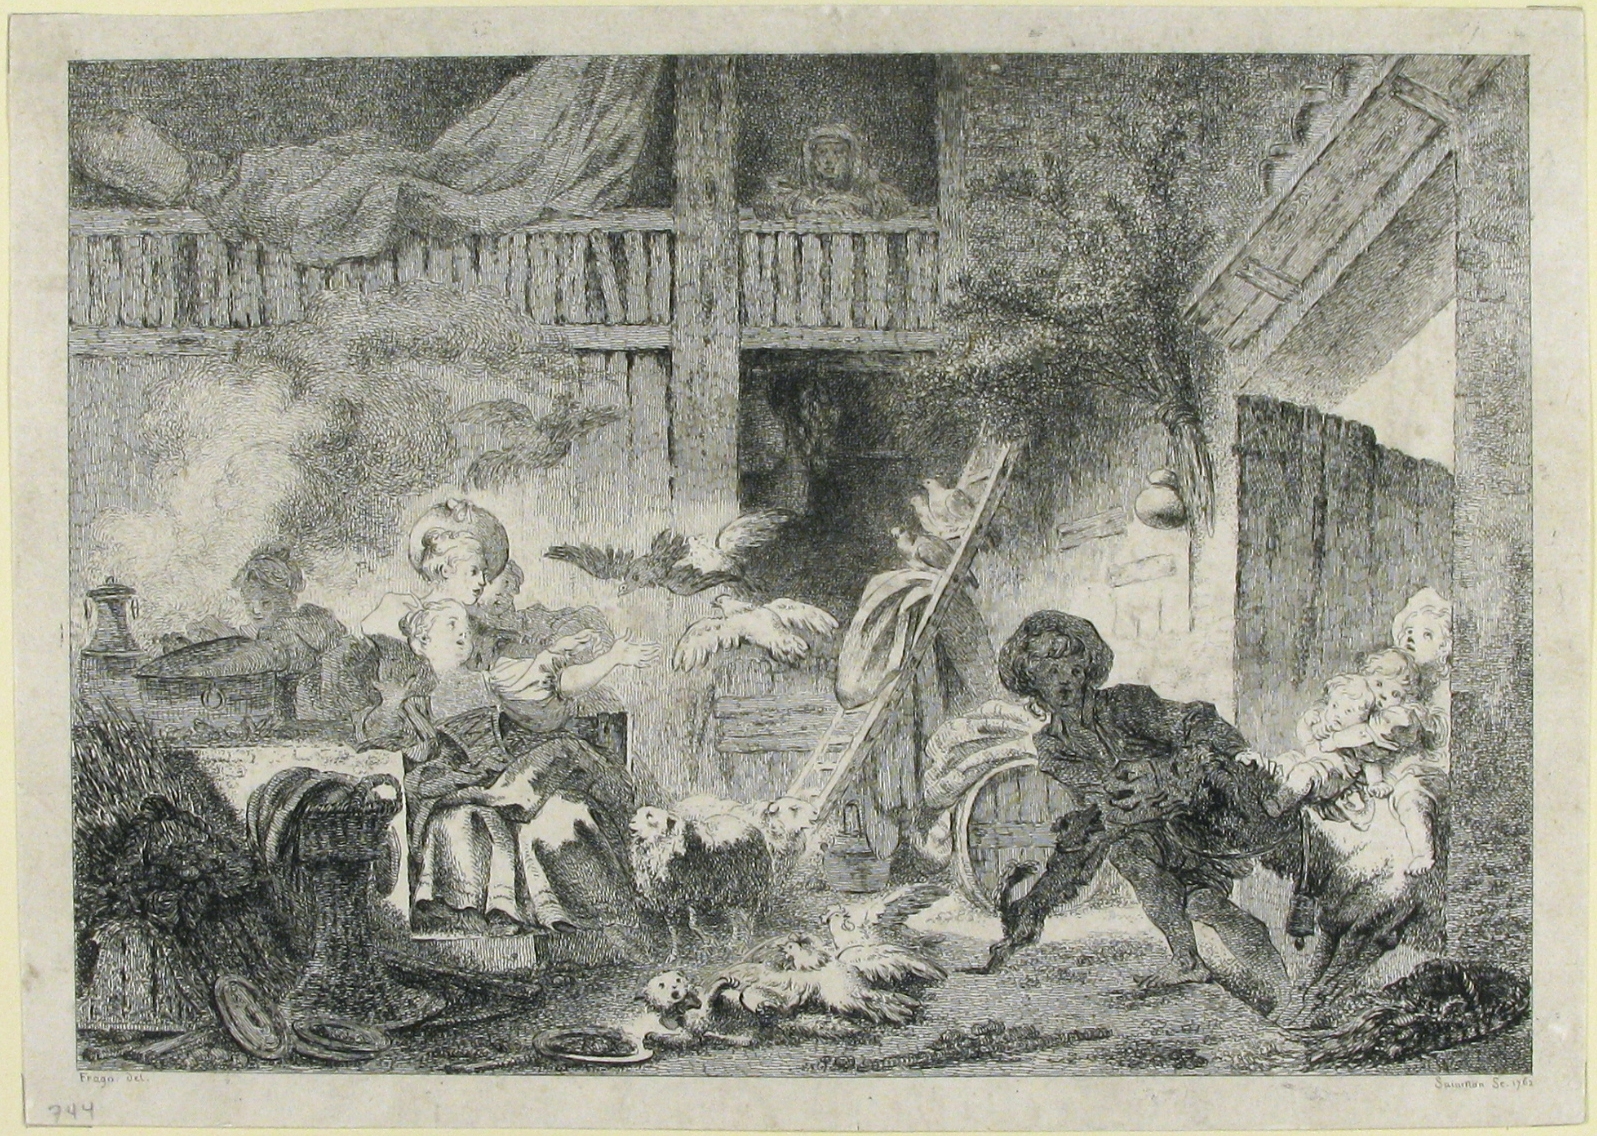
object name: print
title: La Cour de Ferme (1762)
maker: jean claude richard, abbé de saint-non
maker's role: etcher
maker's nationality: french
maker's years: 1727-1791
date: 1762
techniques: etching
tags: animals,birds,children,women